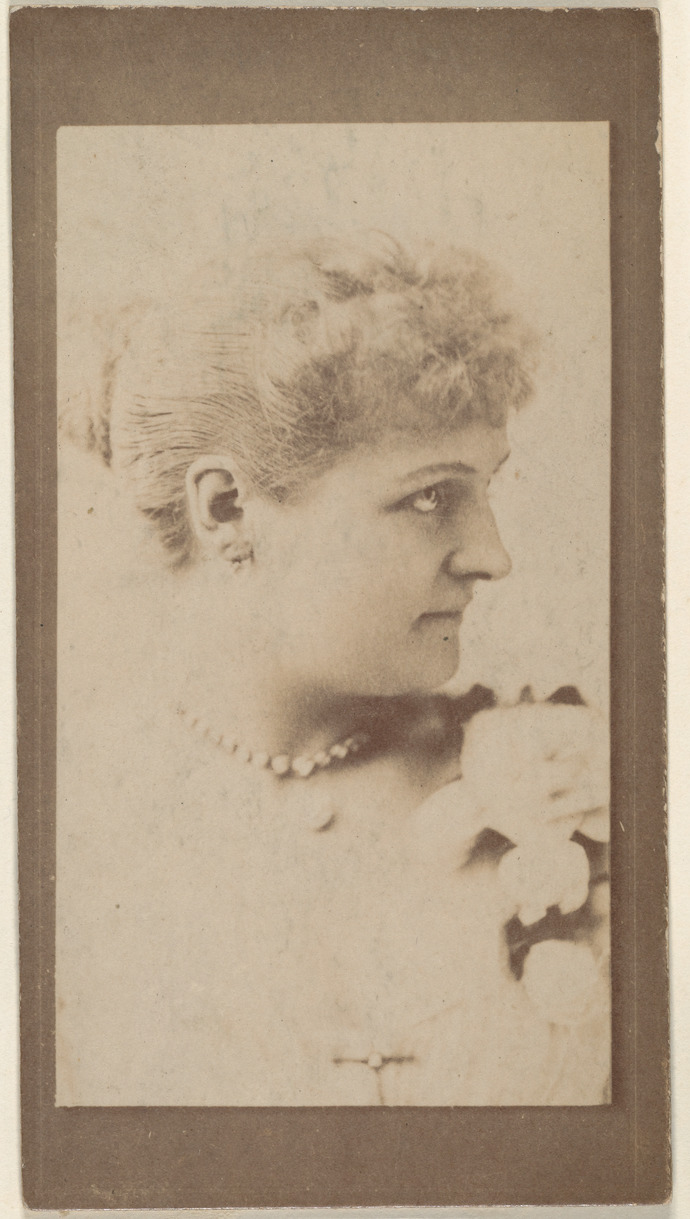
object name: photograph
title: Portrait of actress in profile, from the Actresses series (N668)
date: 1888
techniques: albumen silver print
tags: portraits,profiles,women,actresses